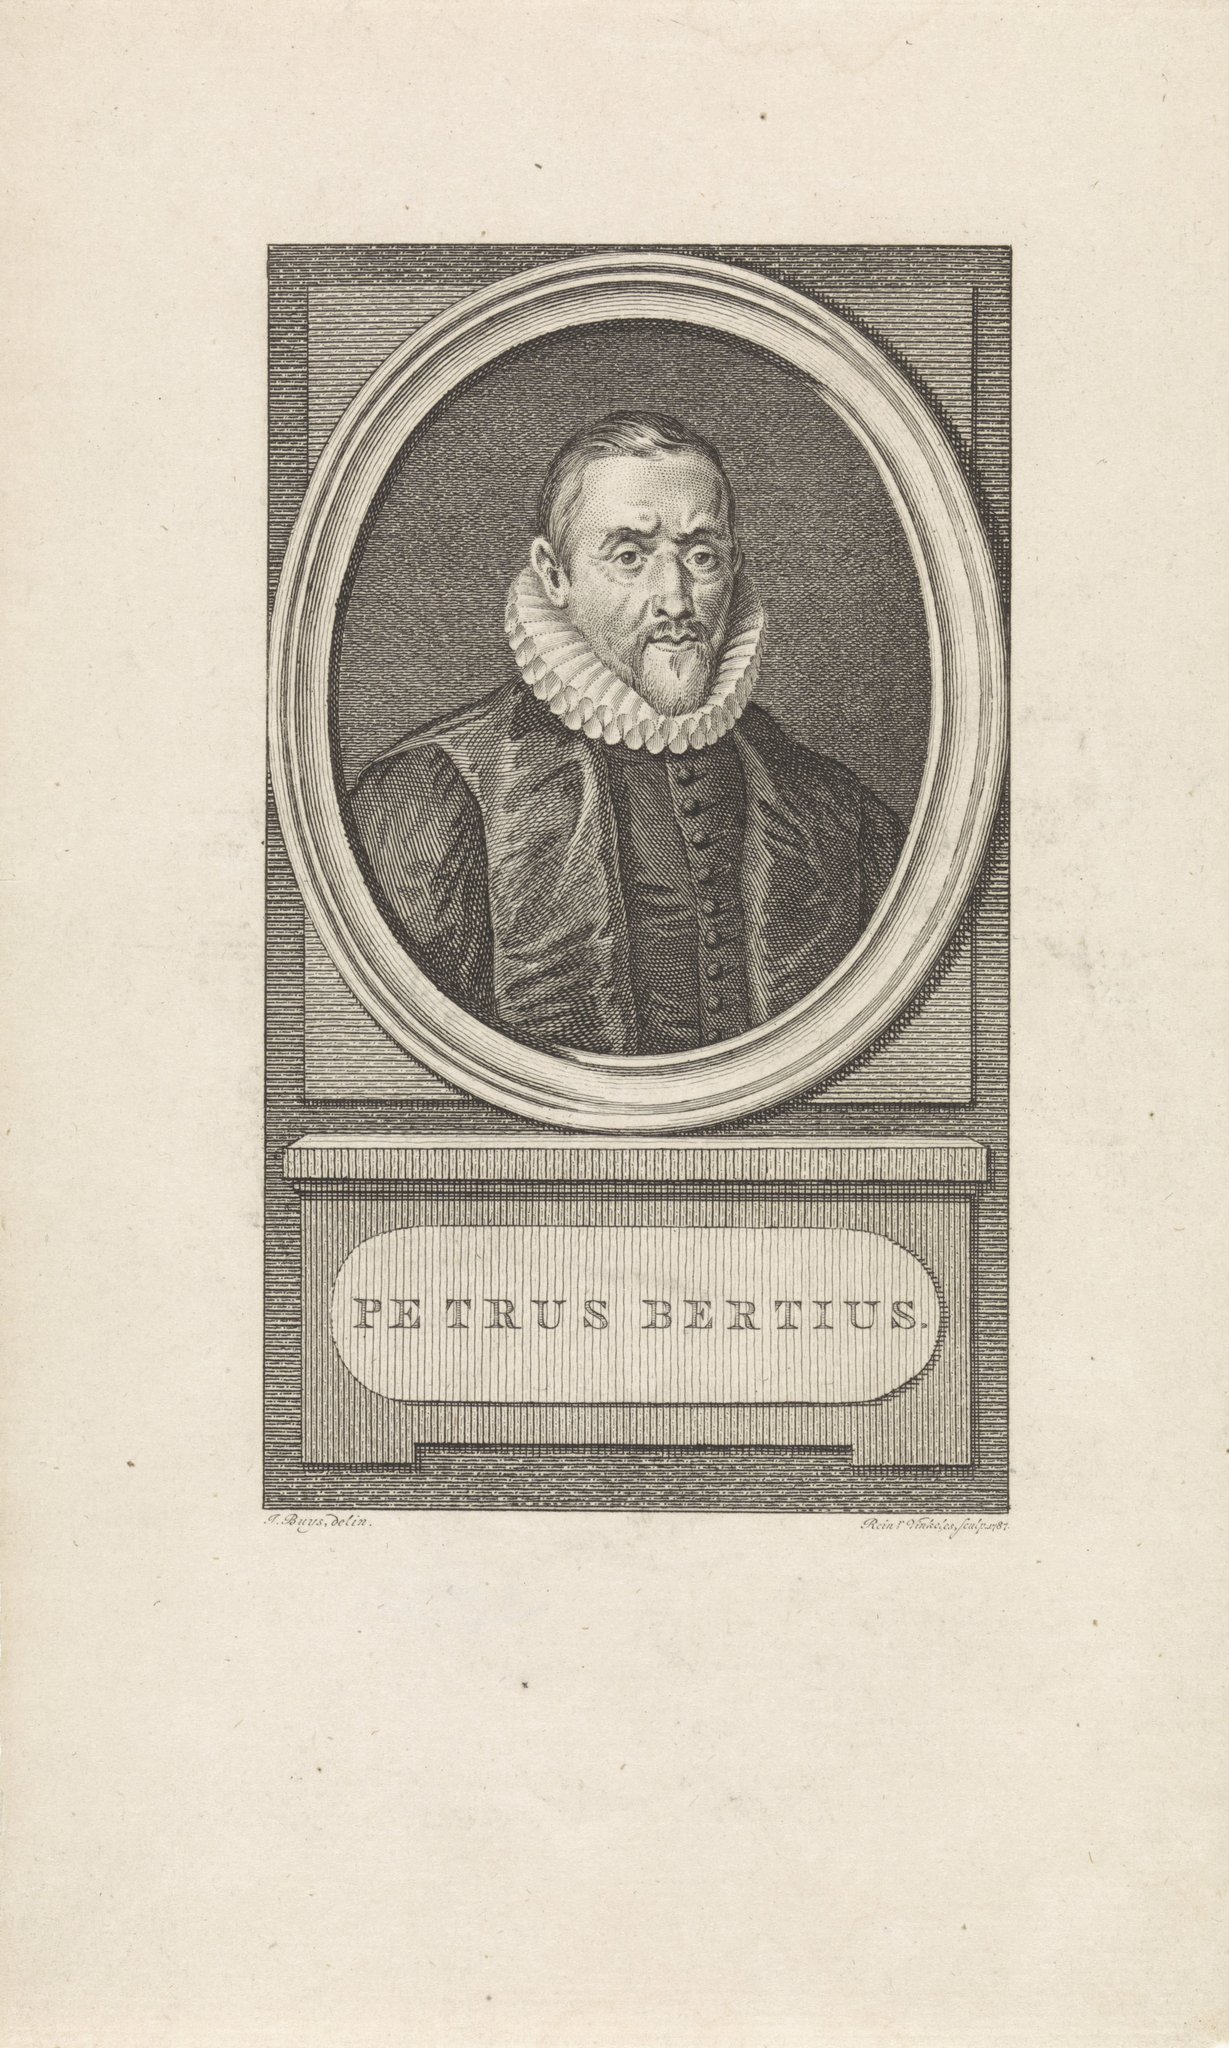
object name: print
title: Portret van Pertrus Bertius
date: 1787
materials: paper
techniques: engraving, etching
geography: amsterdam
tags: paris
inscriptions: collector's mark: Lugt 2228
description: Andere staat prent gebruikt als boekillustratie in: Kok, Jacobus. Vaderlandsch woordenboek : met kaarten, plaaten en pourtraitten. Amsterdam: Johannes Allart, 1785-1796. Deel VI.